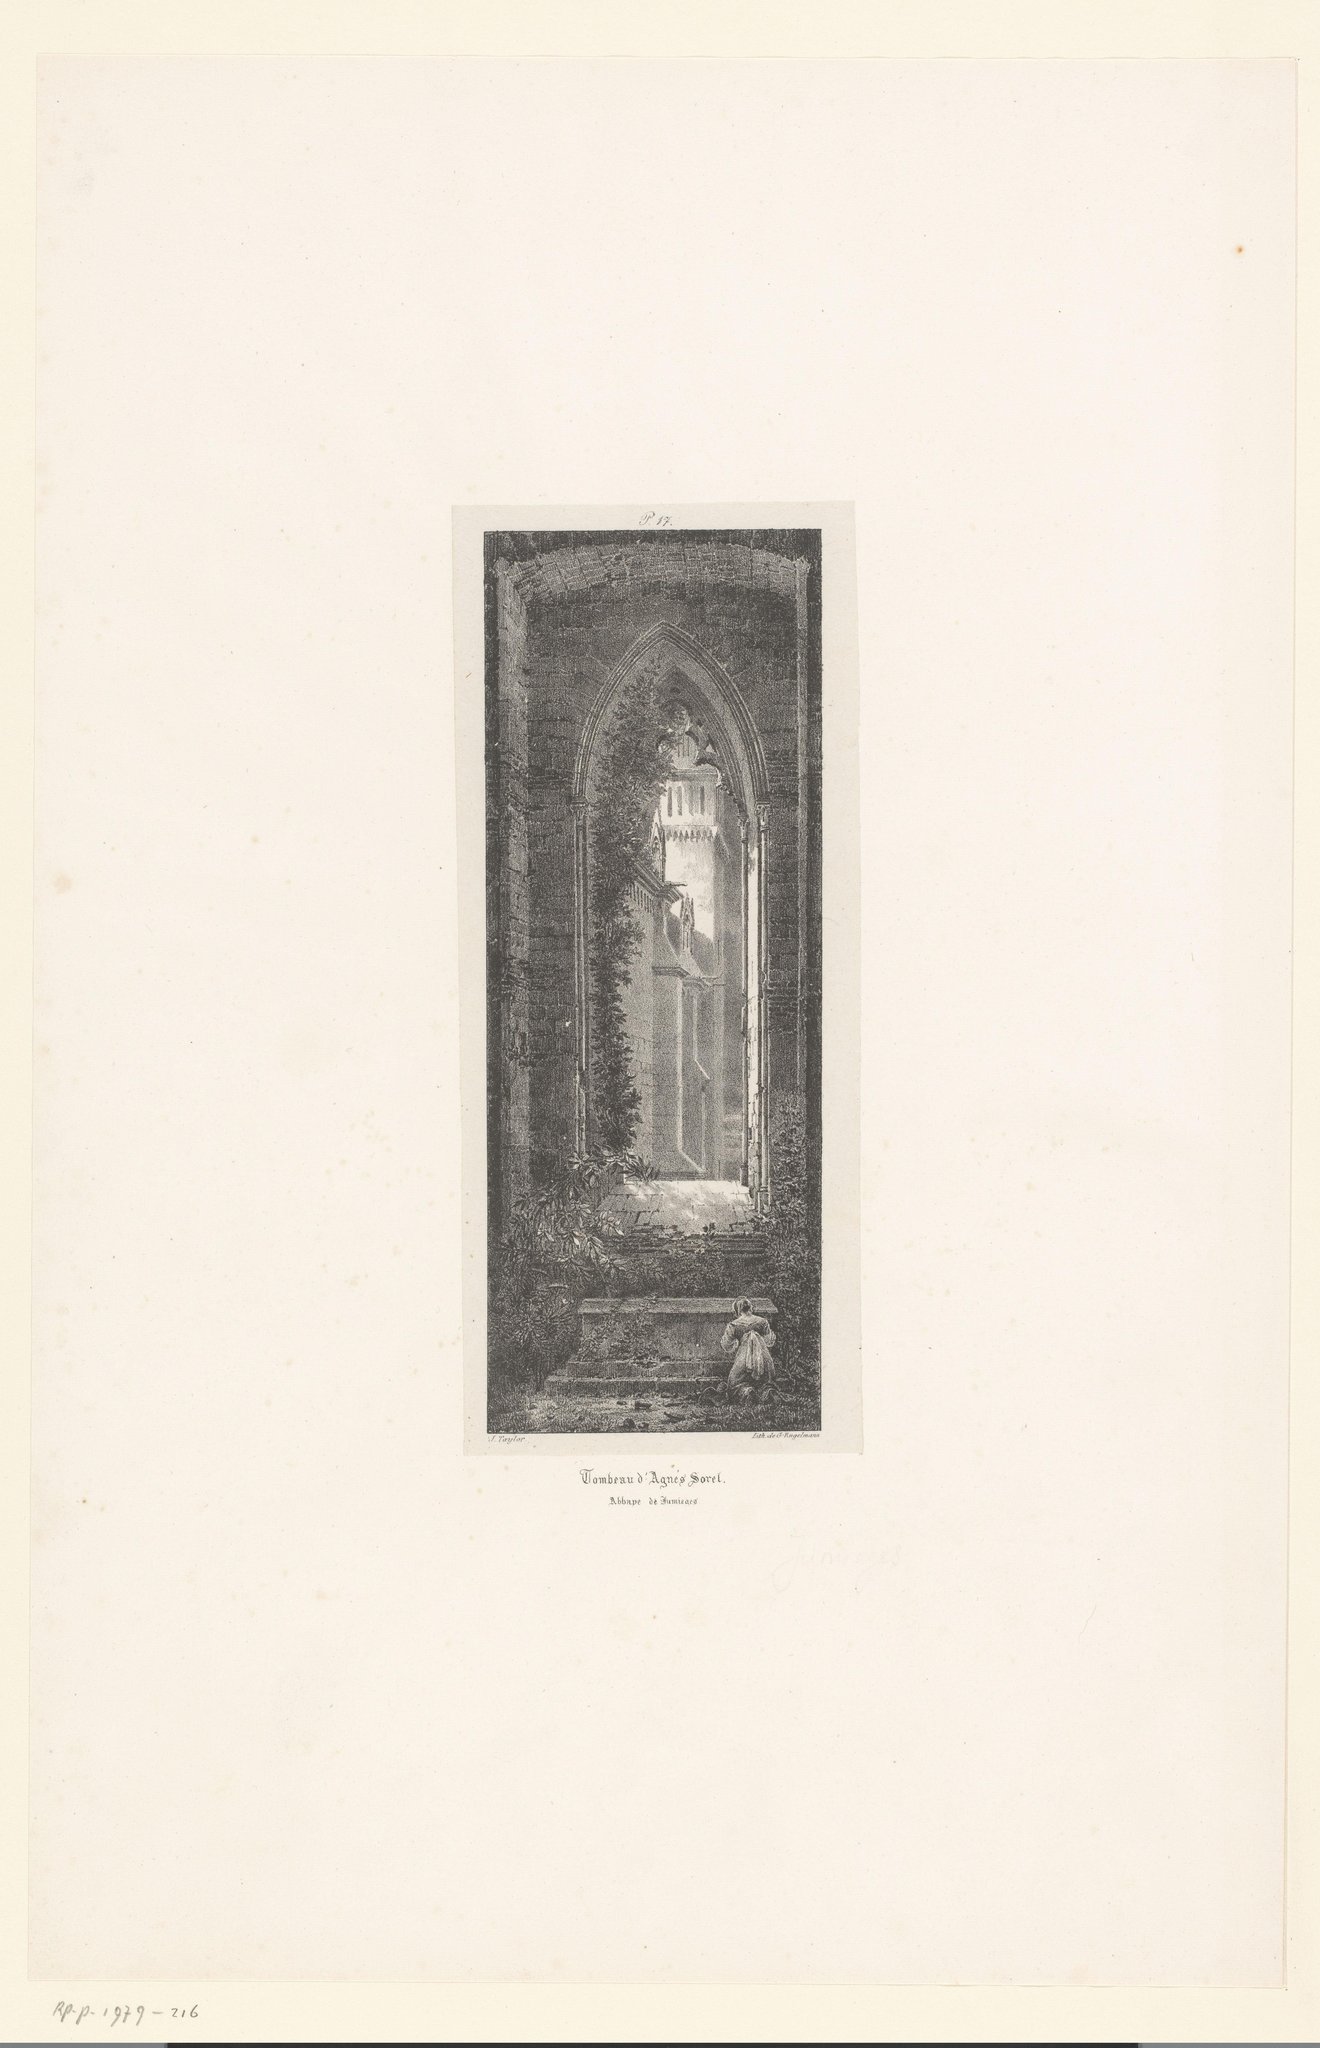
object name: print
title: Graf van Agnes Sorel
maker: gottfried engelmann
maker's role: print maker, printer, publisher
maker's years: 1788-1839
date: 1799-1839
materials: paper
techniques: lithograph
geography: paris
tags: grave, tomb, ruin of church, monastery, etc.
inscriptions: collector's mark: Lugt 2760, collector's mark: Lugt 2228